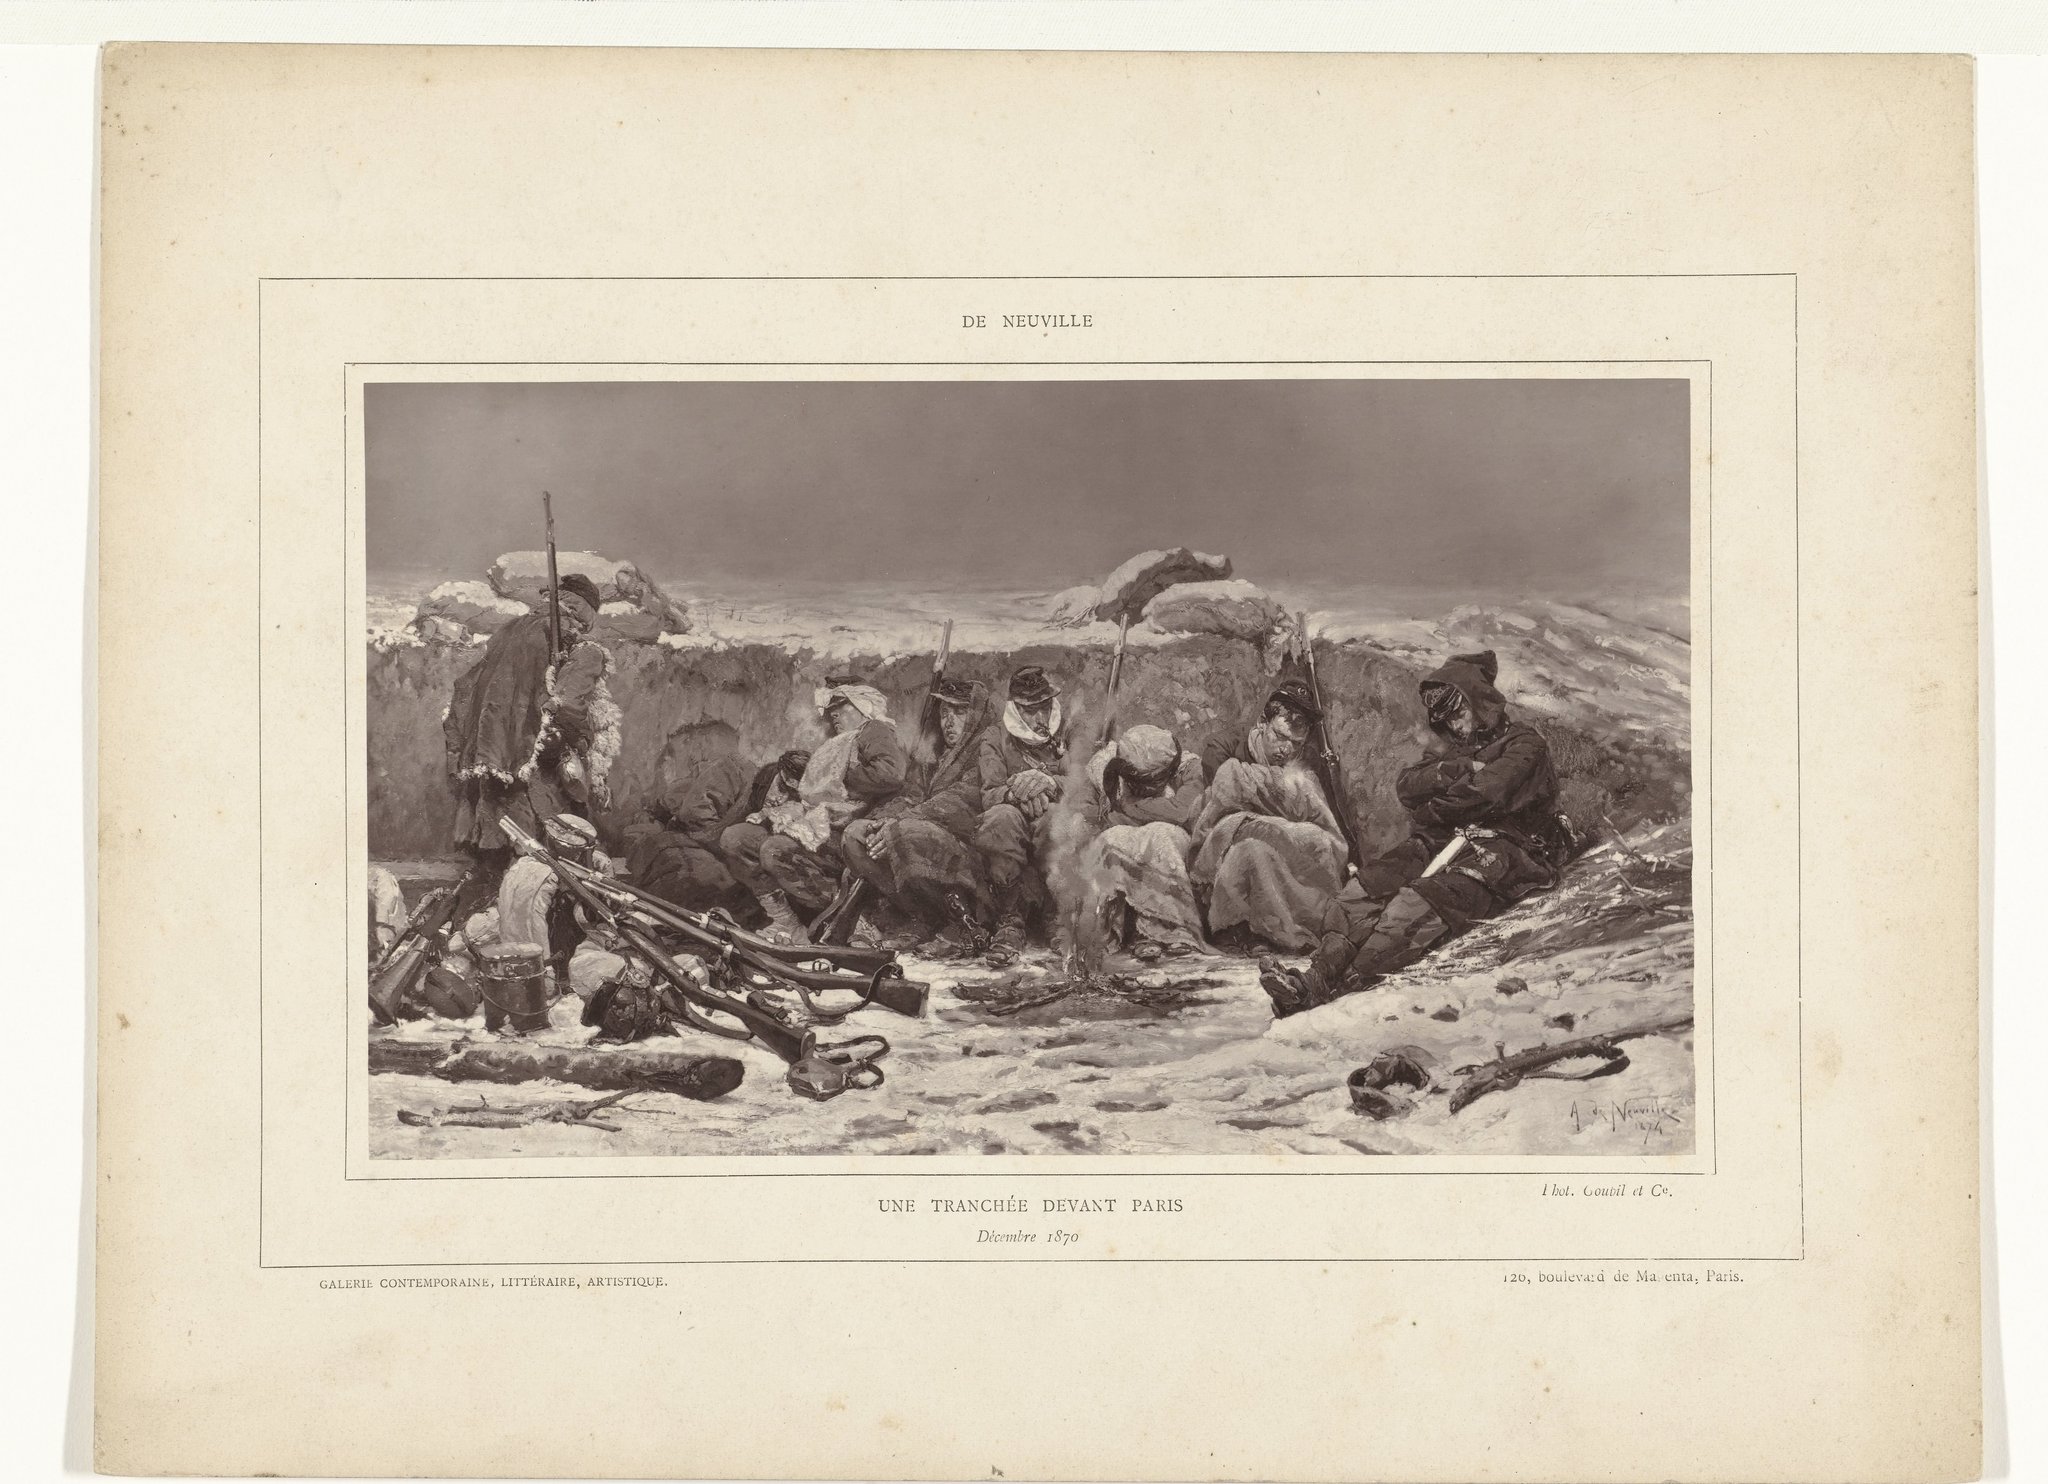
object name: reproduction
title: Reproductie van het schilderij 'Une tranchée devant Paris' door Alphonse de Neuville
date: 1874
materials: cardboard, paper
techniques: woodburytype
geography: paris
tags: sitting on the ground, guard duty, keeping sentry, trenches, france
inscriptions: inscription: ‘Galerie Contemporaine, Literaire, Artistique. 126, boulevard de Magenta, Paris’, inscription: ‘De Neuville/ Une tranchée devant Paris/ Décembre 1870/ Phot. Goupil & Cie’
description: Het schilderij toont soldaten in een loopgraaf voor Parijs tijdens de Frans-Duitse oorlog.